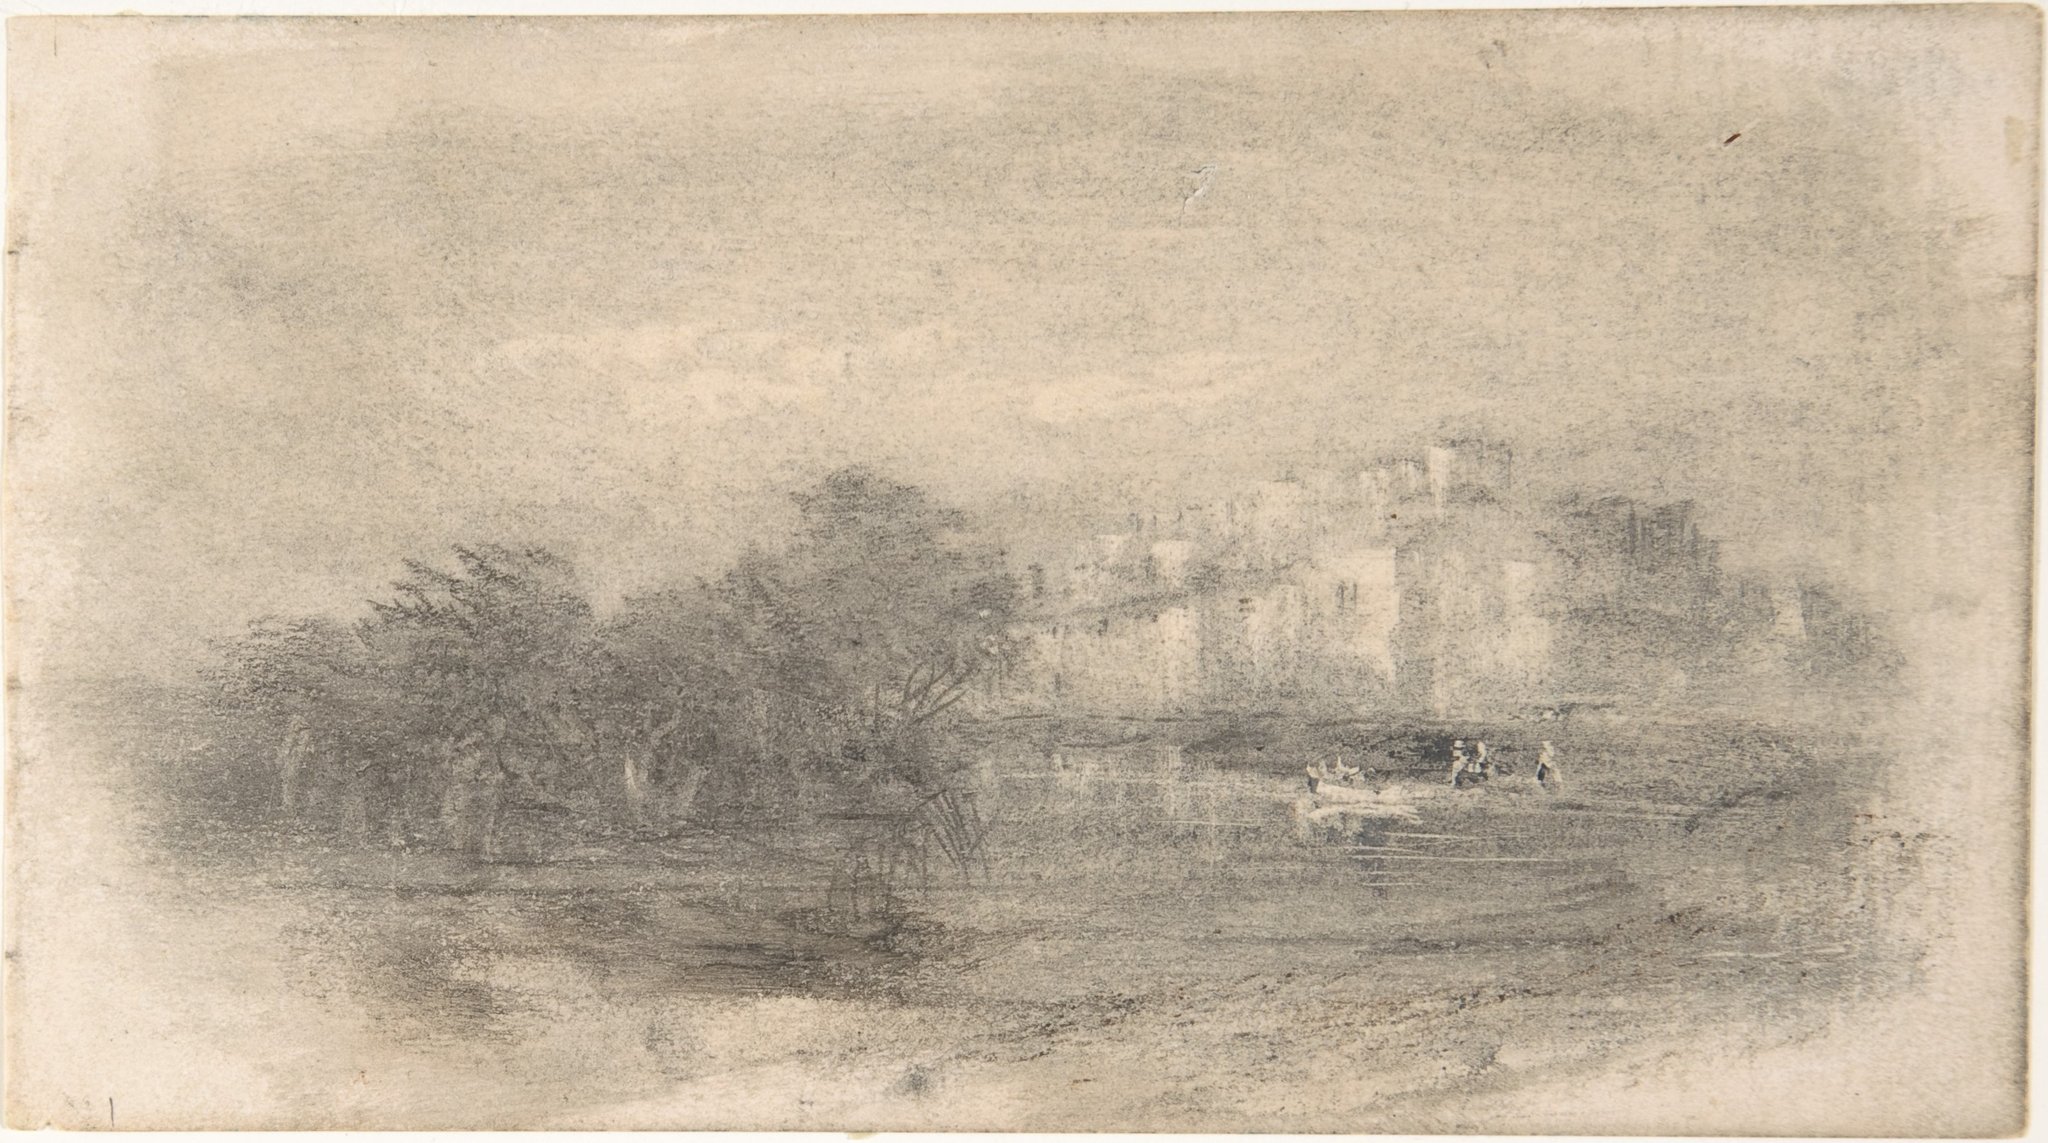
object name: drawing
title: Landscape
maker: anonymous, british, early 19th century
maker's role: artist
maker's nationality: british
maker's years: 1800-1850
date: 1801-1833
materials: ink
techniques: brush, pen, wash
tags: landscapes,trees